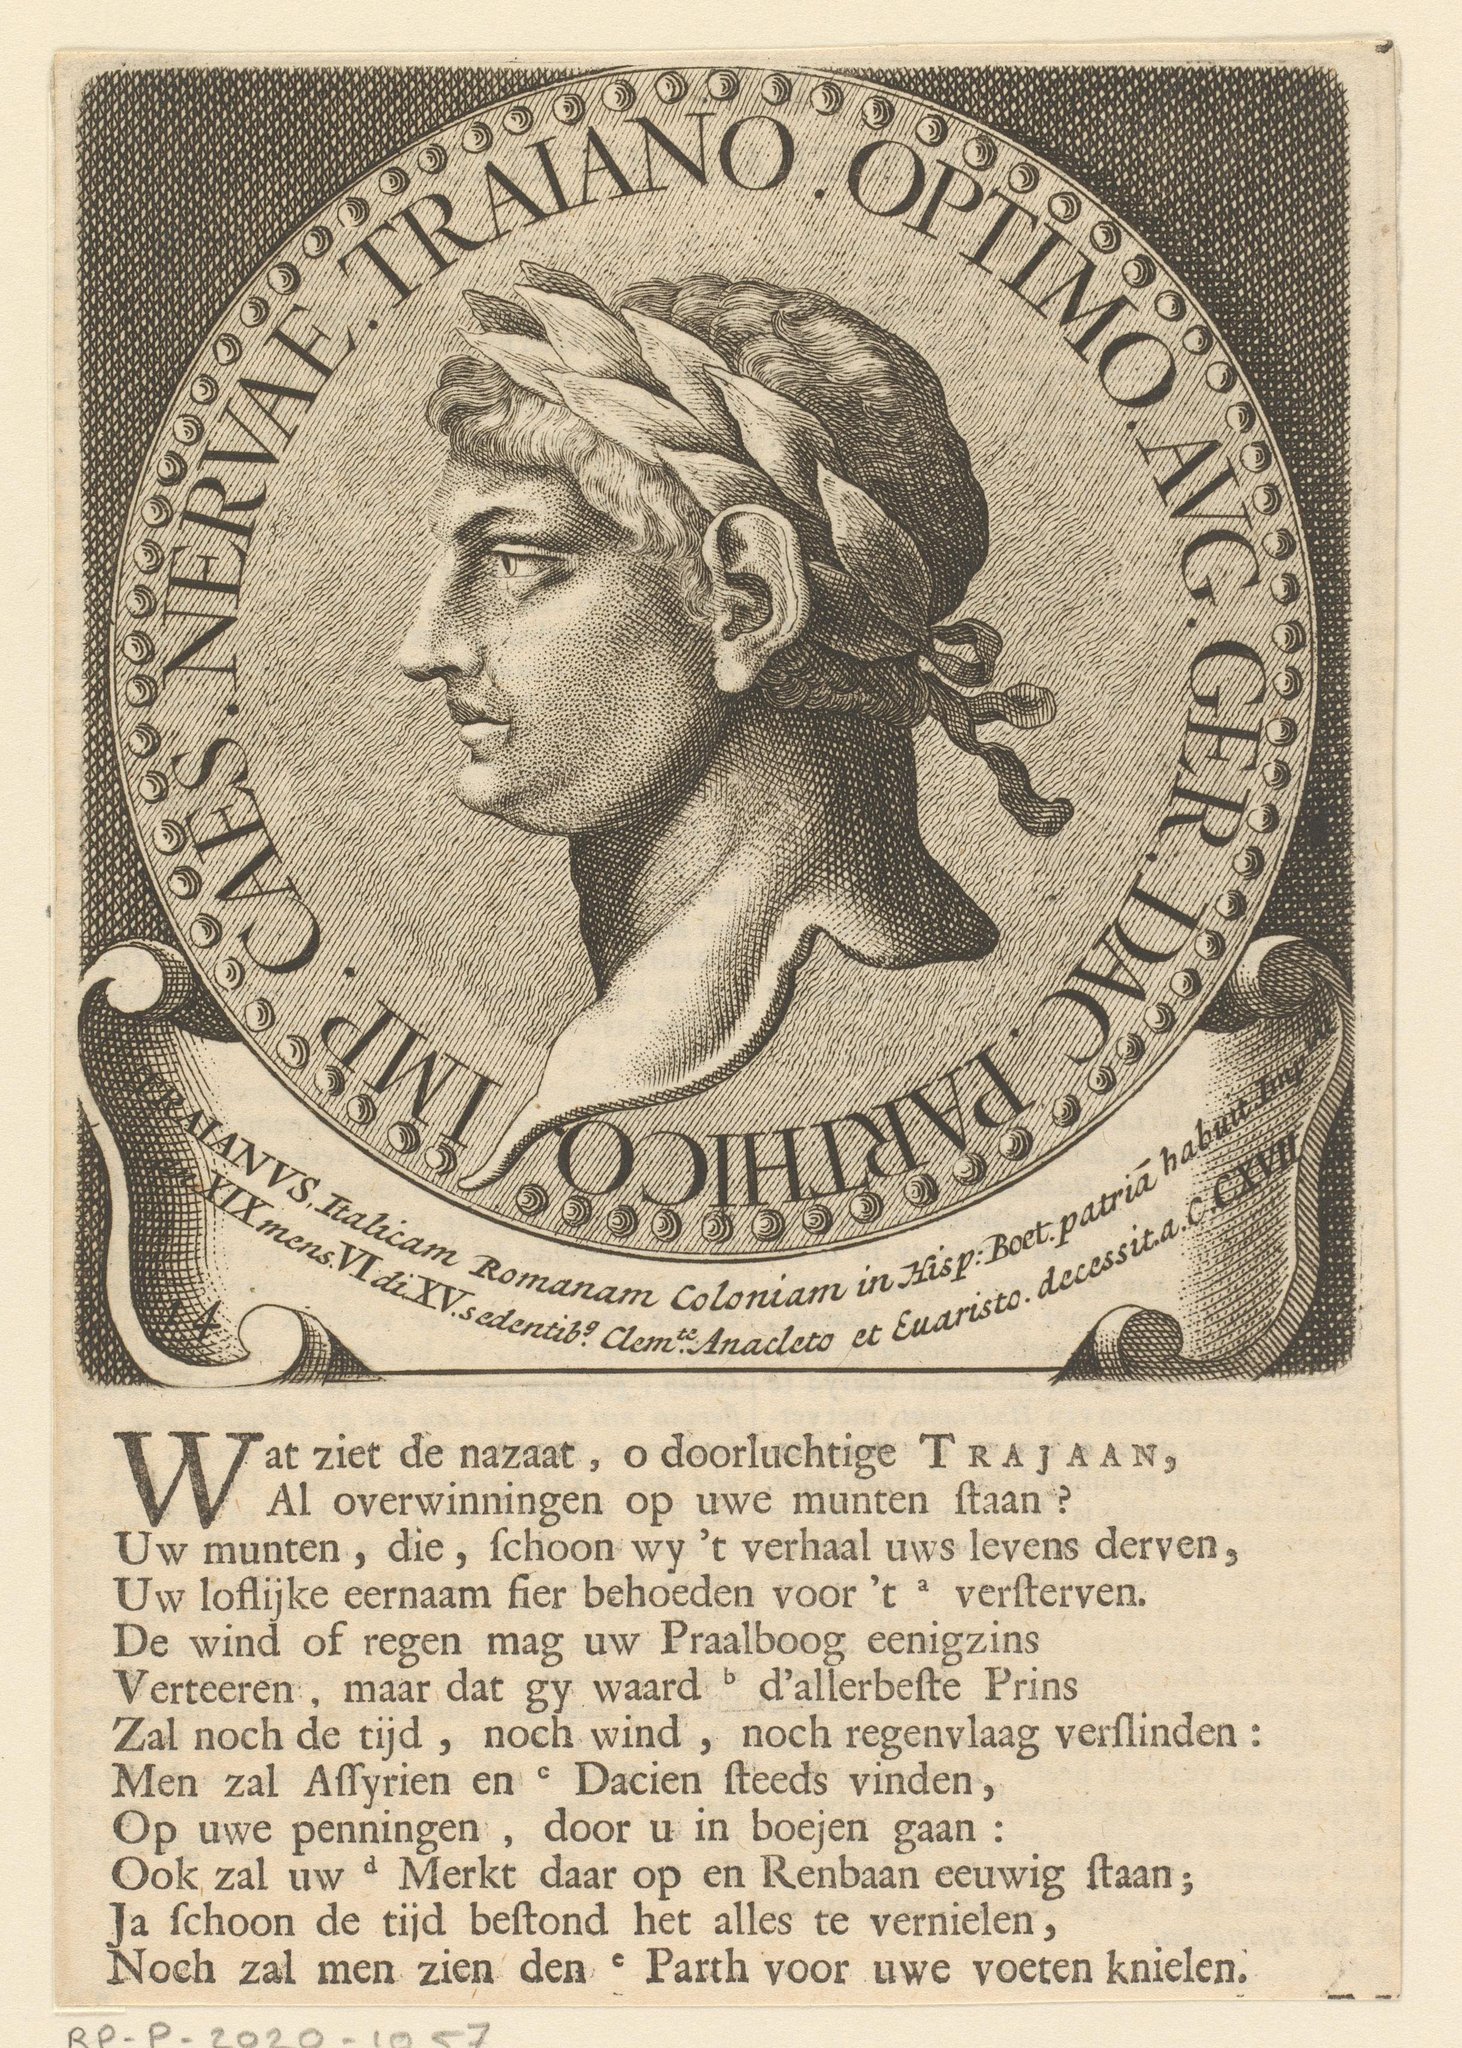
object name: book illustration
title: Trajanus, Italicam Romanam Coloniam in Hisp. (...)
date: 1697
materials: paper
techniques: engraving, etching, letterpress printing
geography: utrecht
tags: historical persons, (story of) the emperor trajan, emperor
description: Prent uit: Bogaert, Abraham. De Roomsche monarchy, vertoont in de muntbeelden der westersche en oostersche keizeren (...). Utrecht: François Halma en Willem van de Water, 1697, p. 135. Eerste staat verschenen in een grotere prent met twaalf portretten, gedateerd 1695.